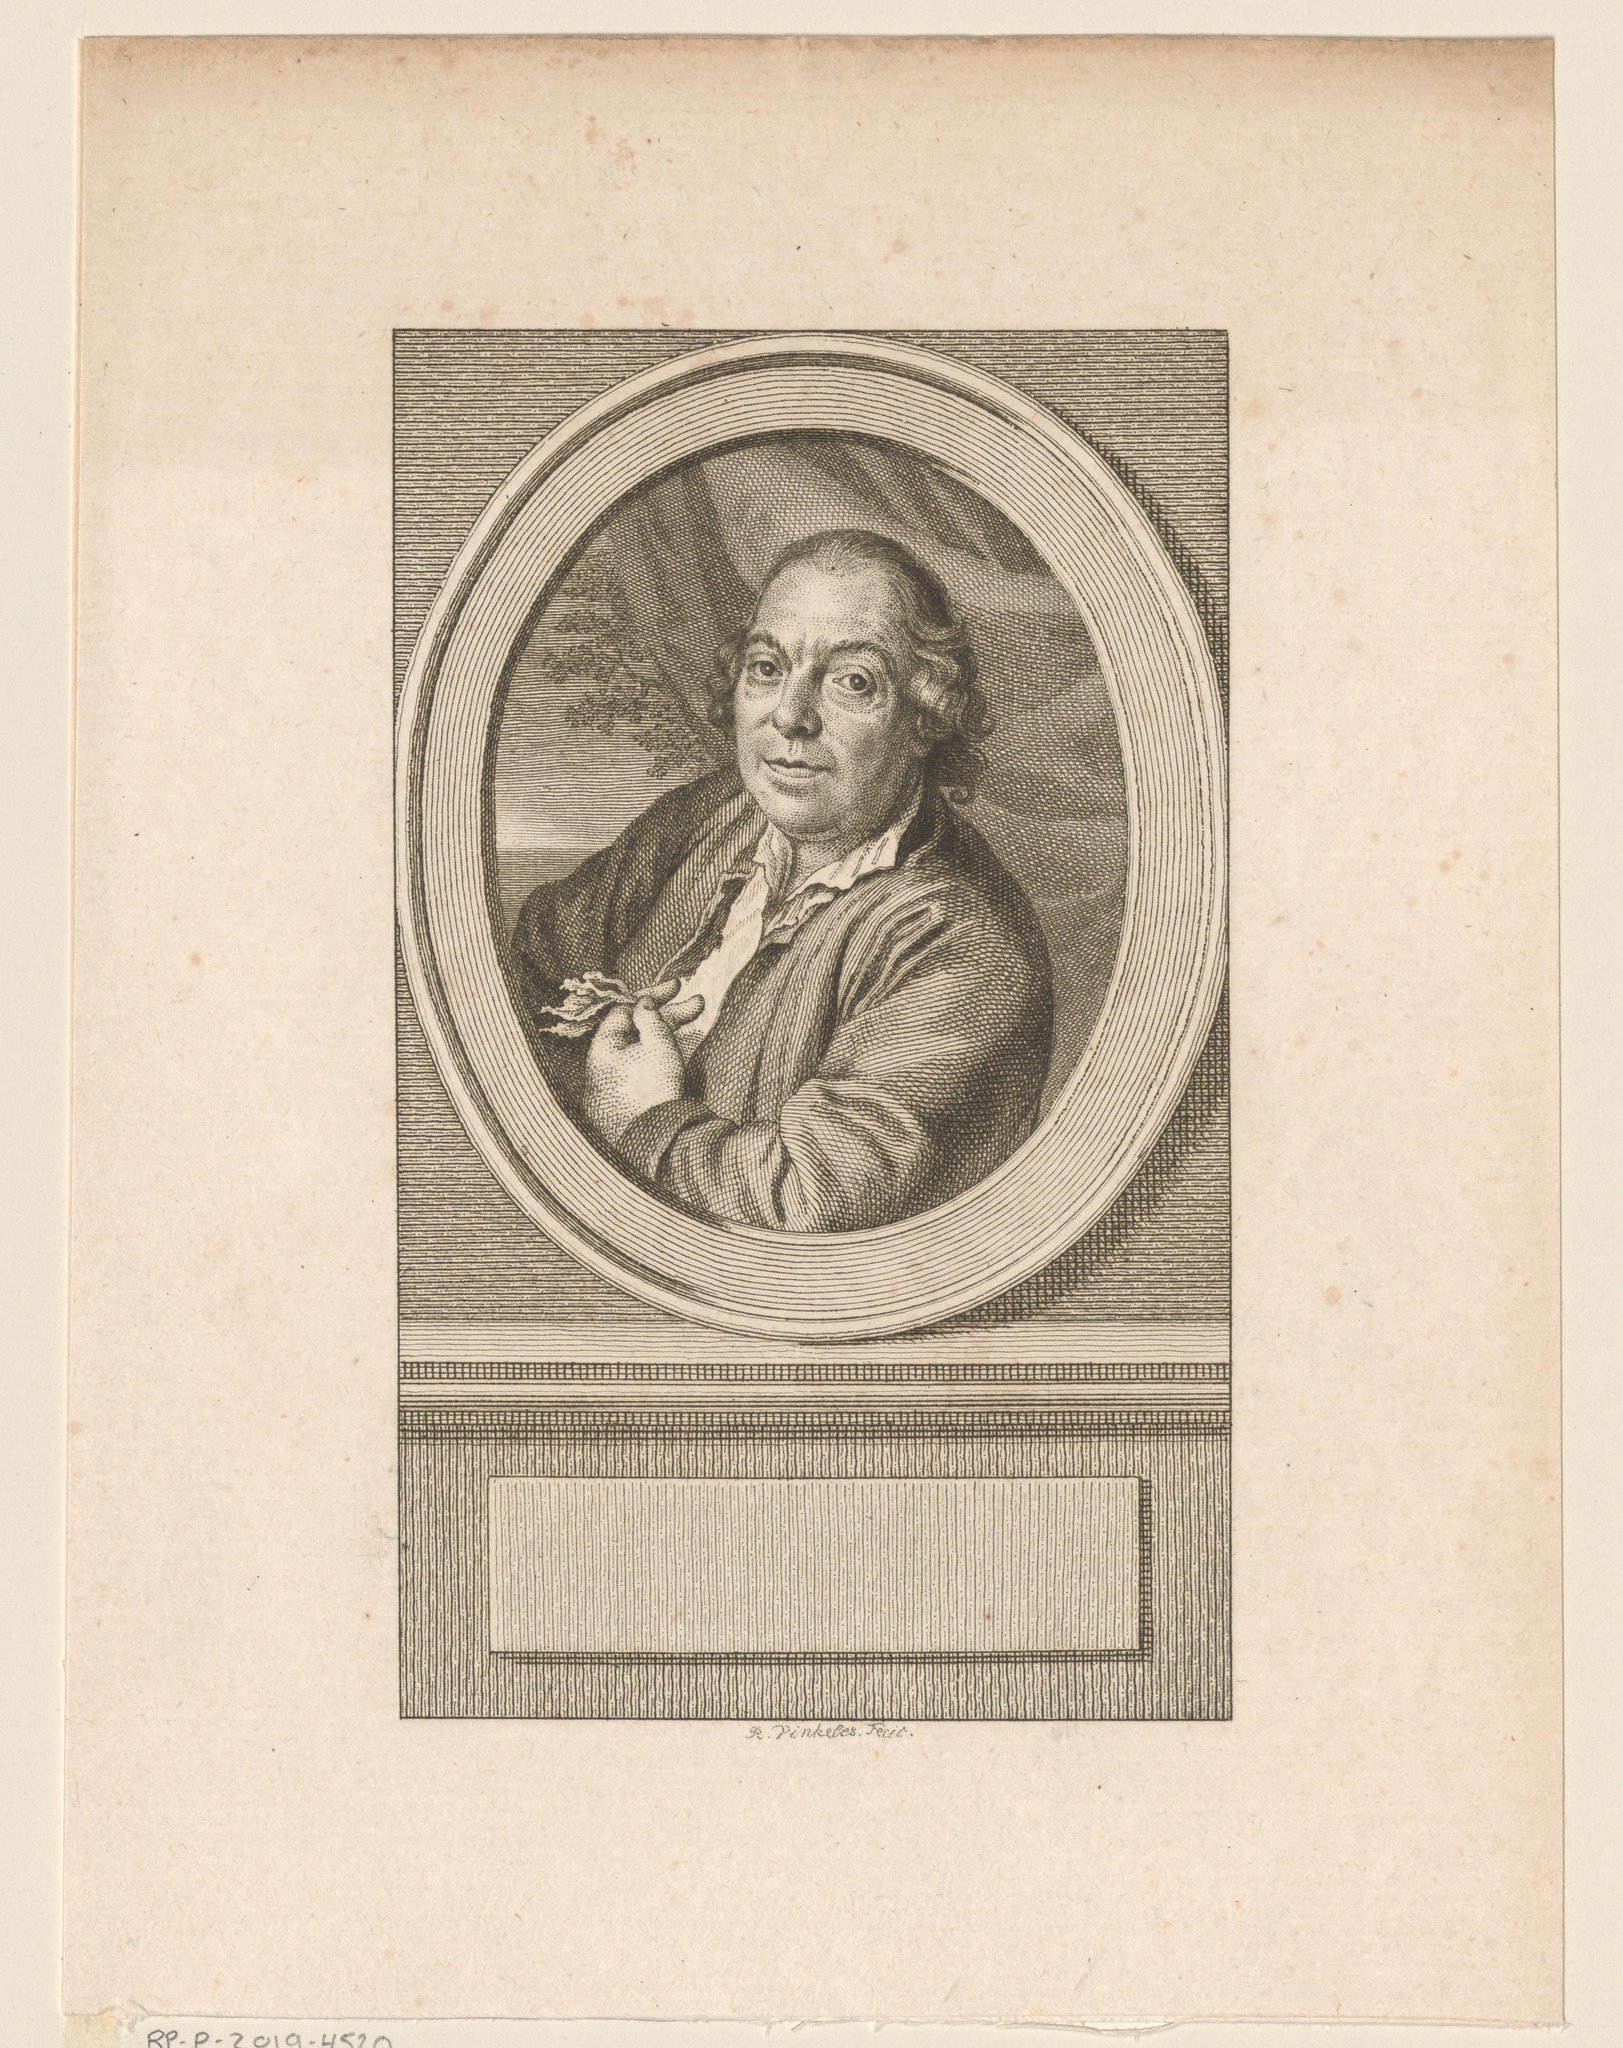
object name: print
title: Portret van Johannes le Francq van Berkhey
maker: reinier vinkeles (i)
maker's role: draughtsman, print maker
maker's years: 1741-1816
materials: paper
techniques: engraving, etching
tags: johannes le francq van berkhey, historical persons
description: Latere staat van de prent gebruikt in: Loosjes, Petrus. Vaderlandsche historie, (...) ten vervolge van Wagenaars Vaderlandsche historie. Amsterdam: Johannes Allart, 1811, dl. 46.